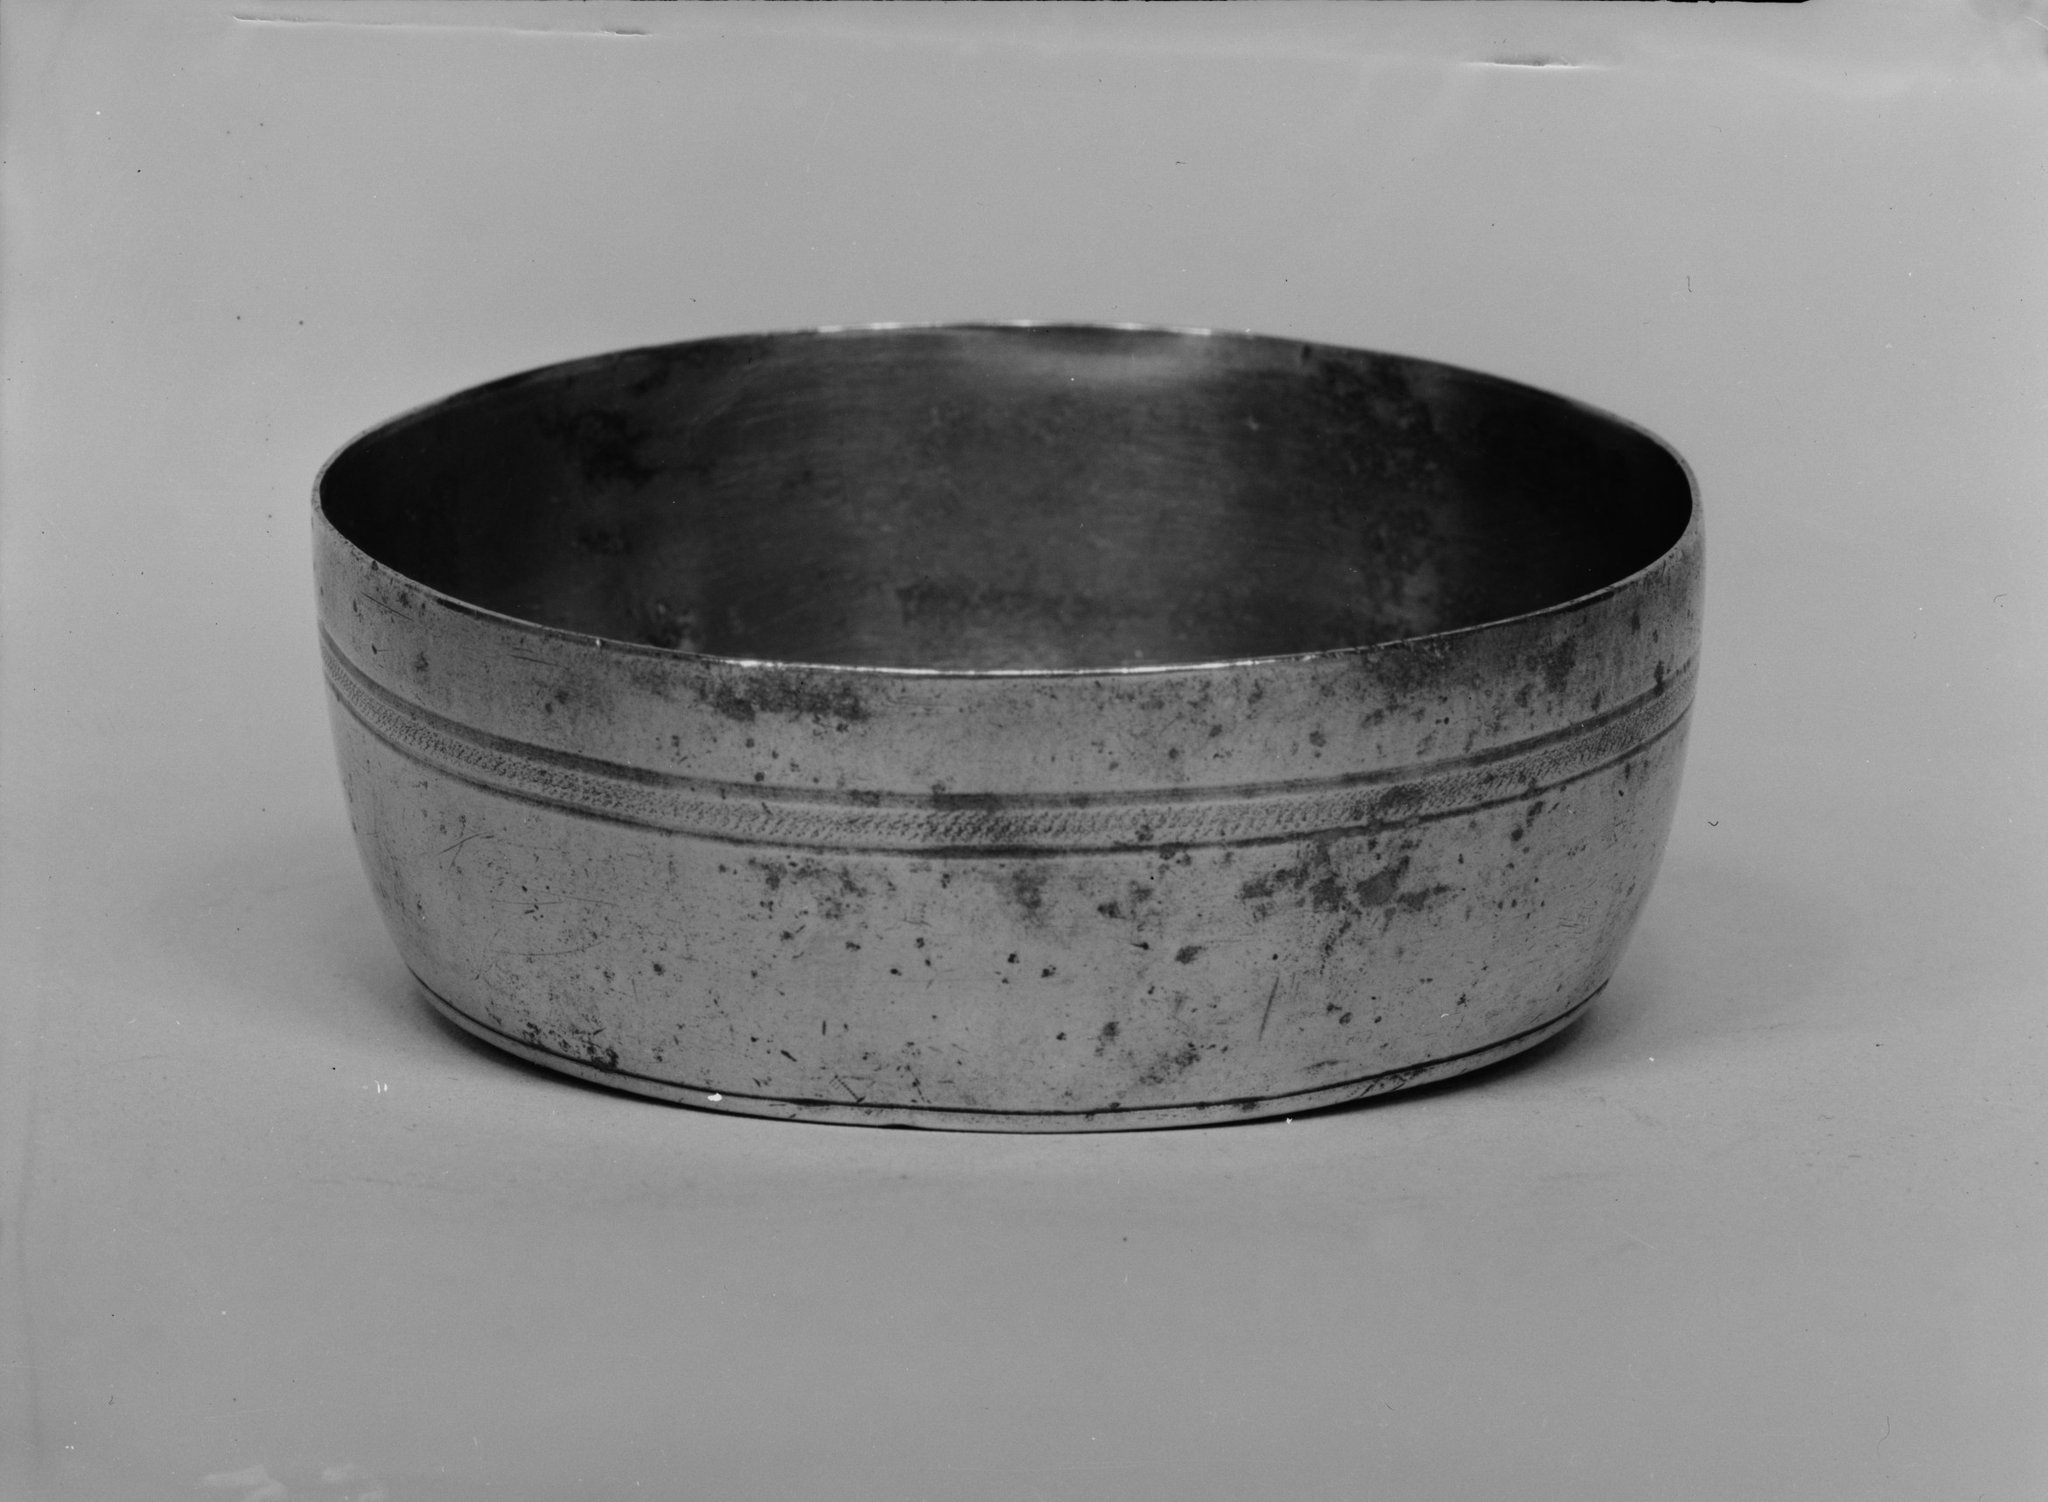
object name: coaster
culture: american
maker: oliver trask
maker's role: maker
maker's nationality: american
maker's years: 1792-1847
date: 1832-1839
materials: pewter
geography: united states